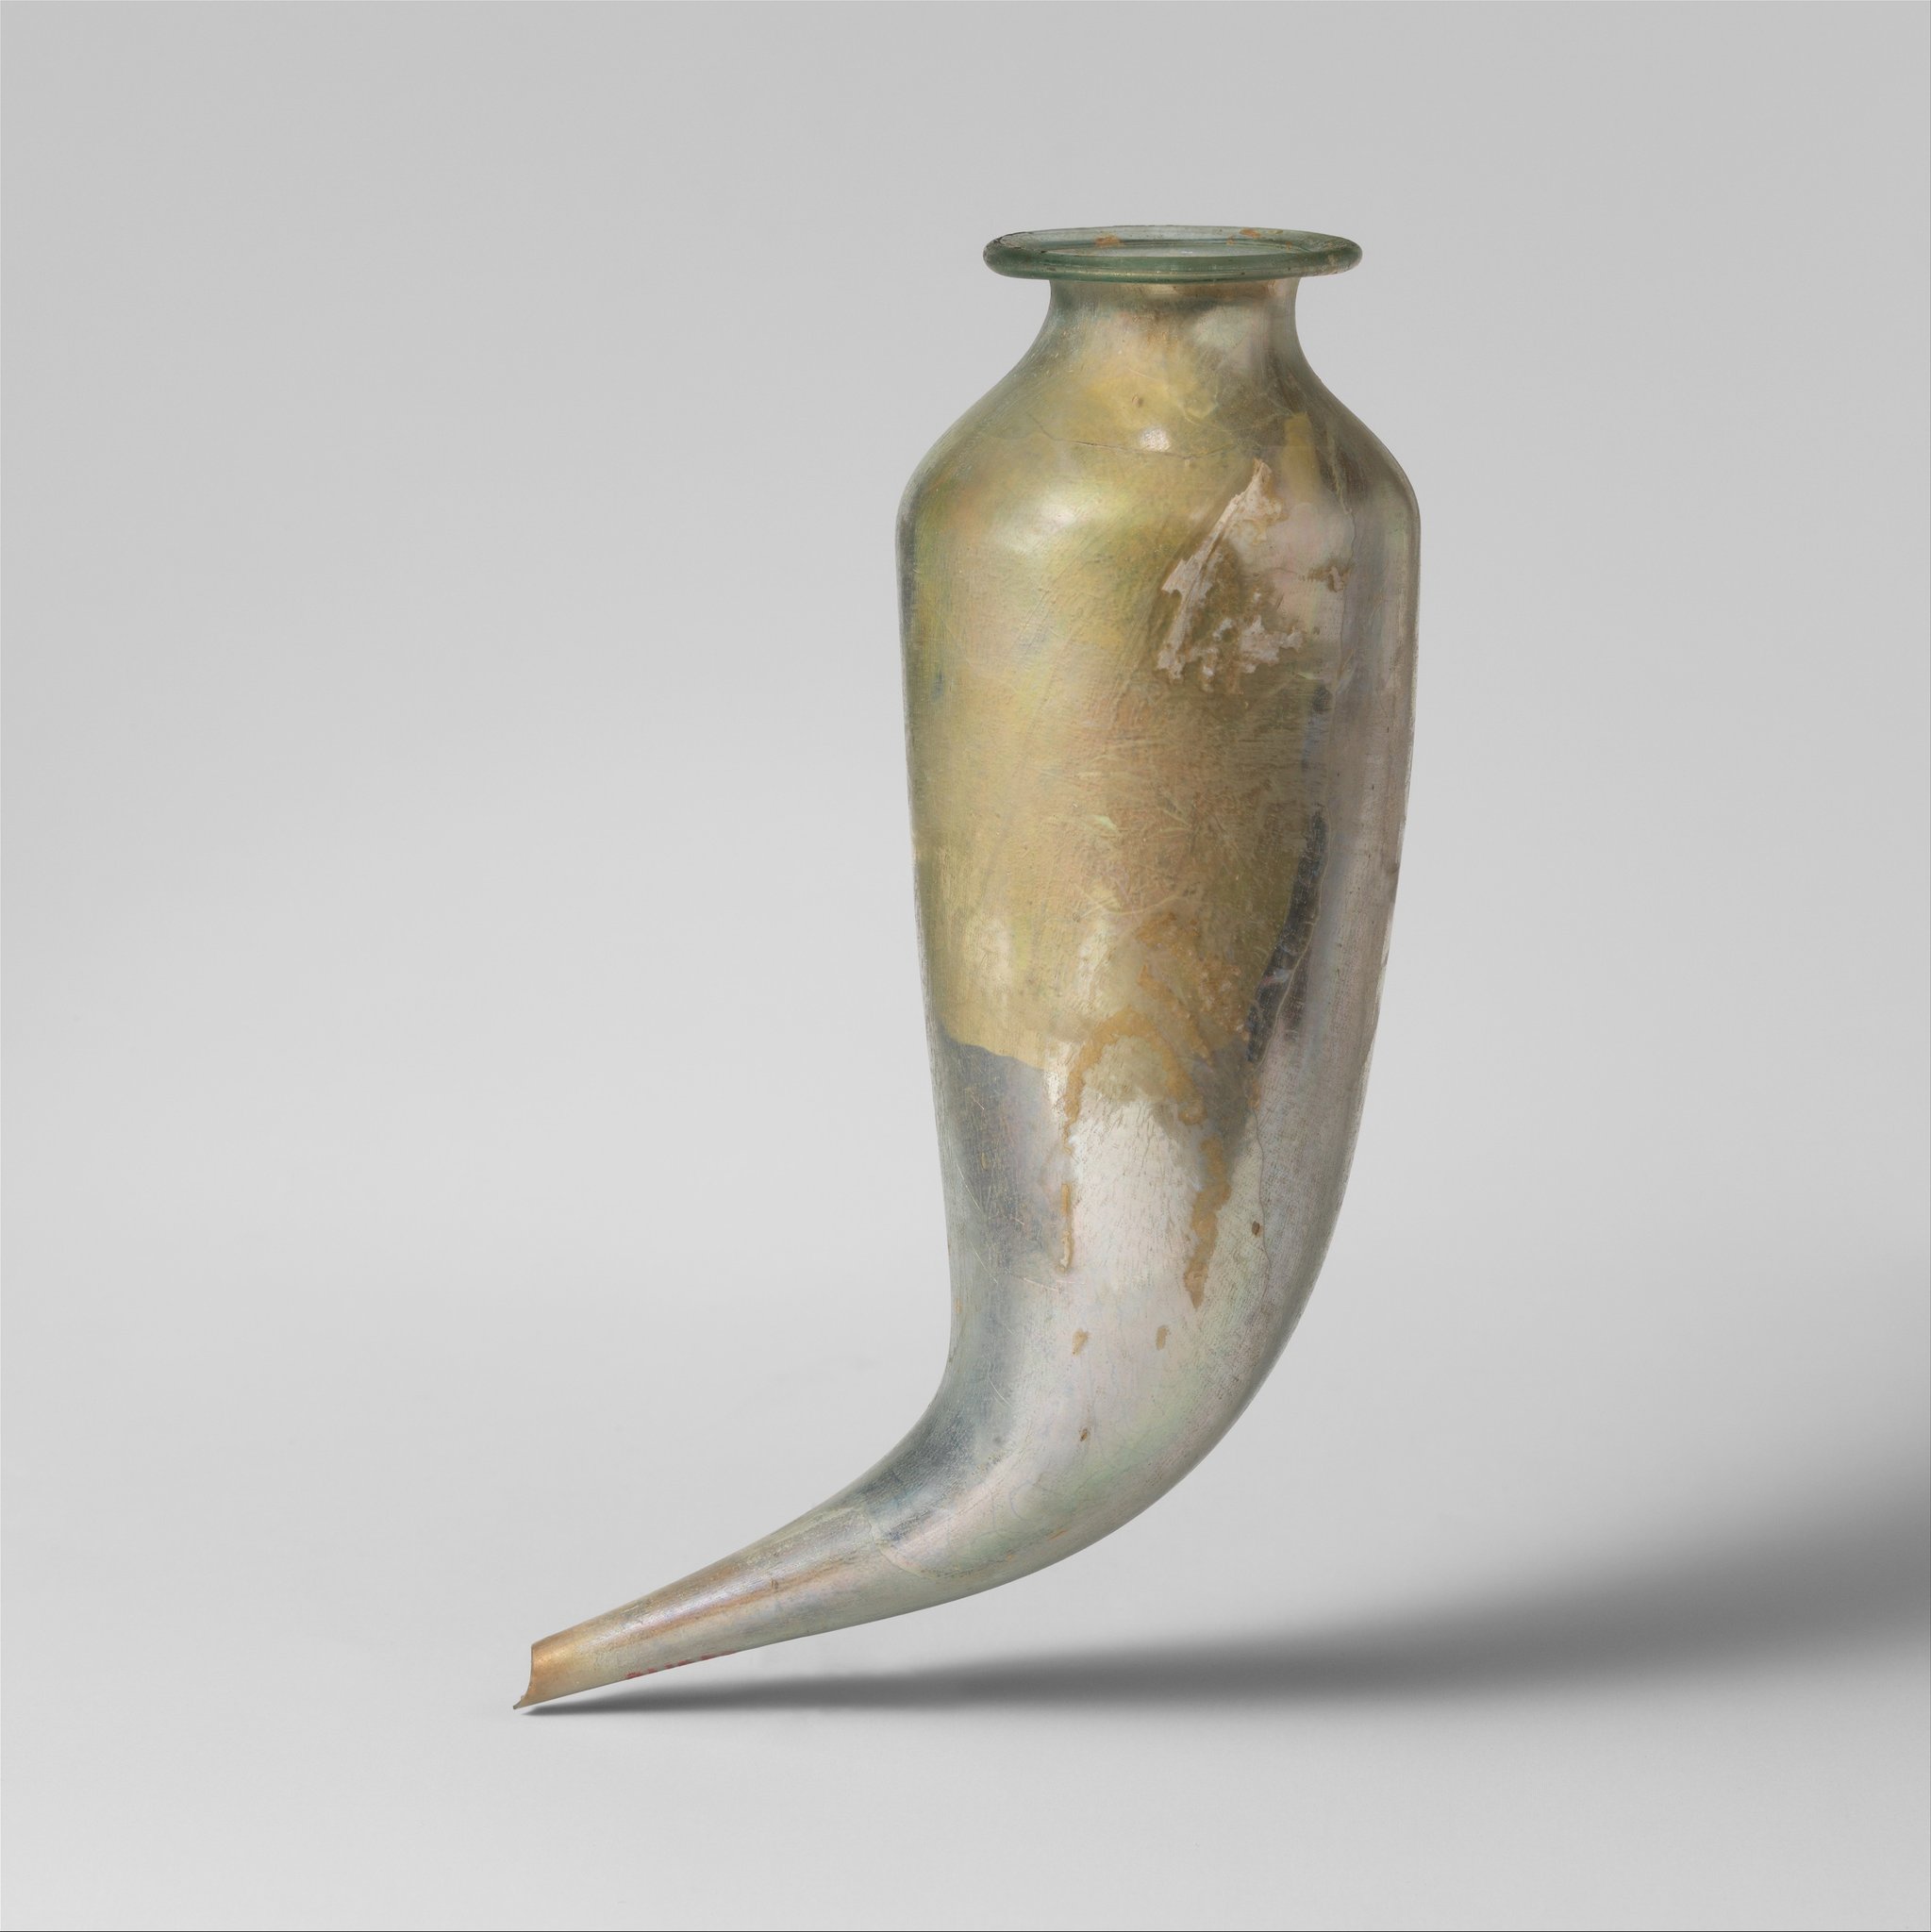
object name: rhyton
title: Glass rhyton (drinking horn)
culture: roman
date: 34-66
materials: glass